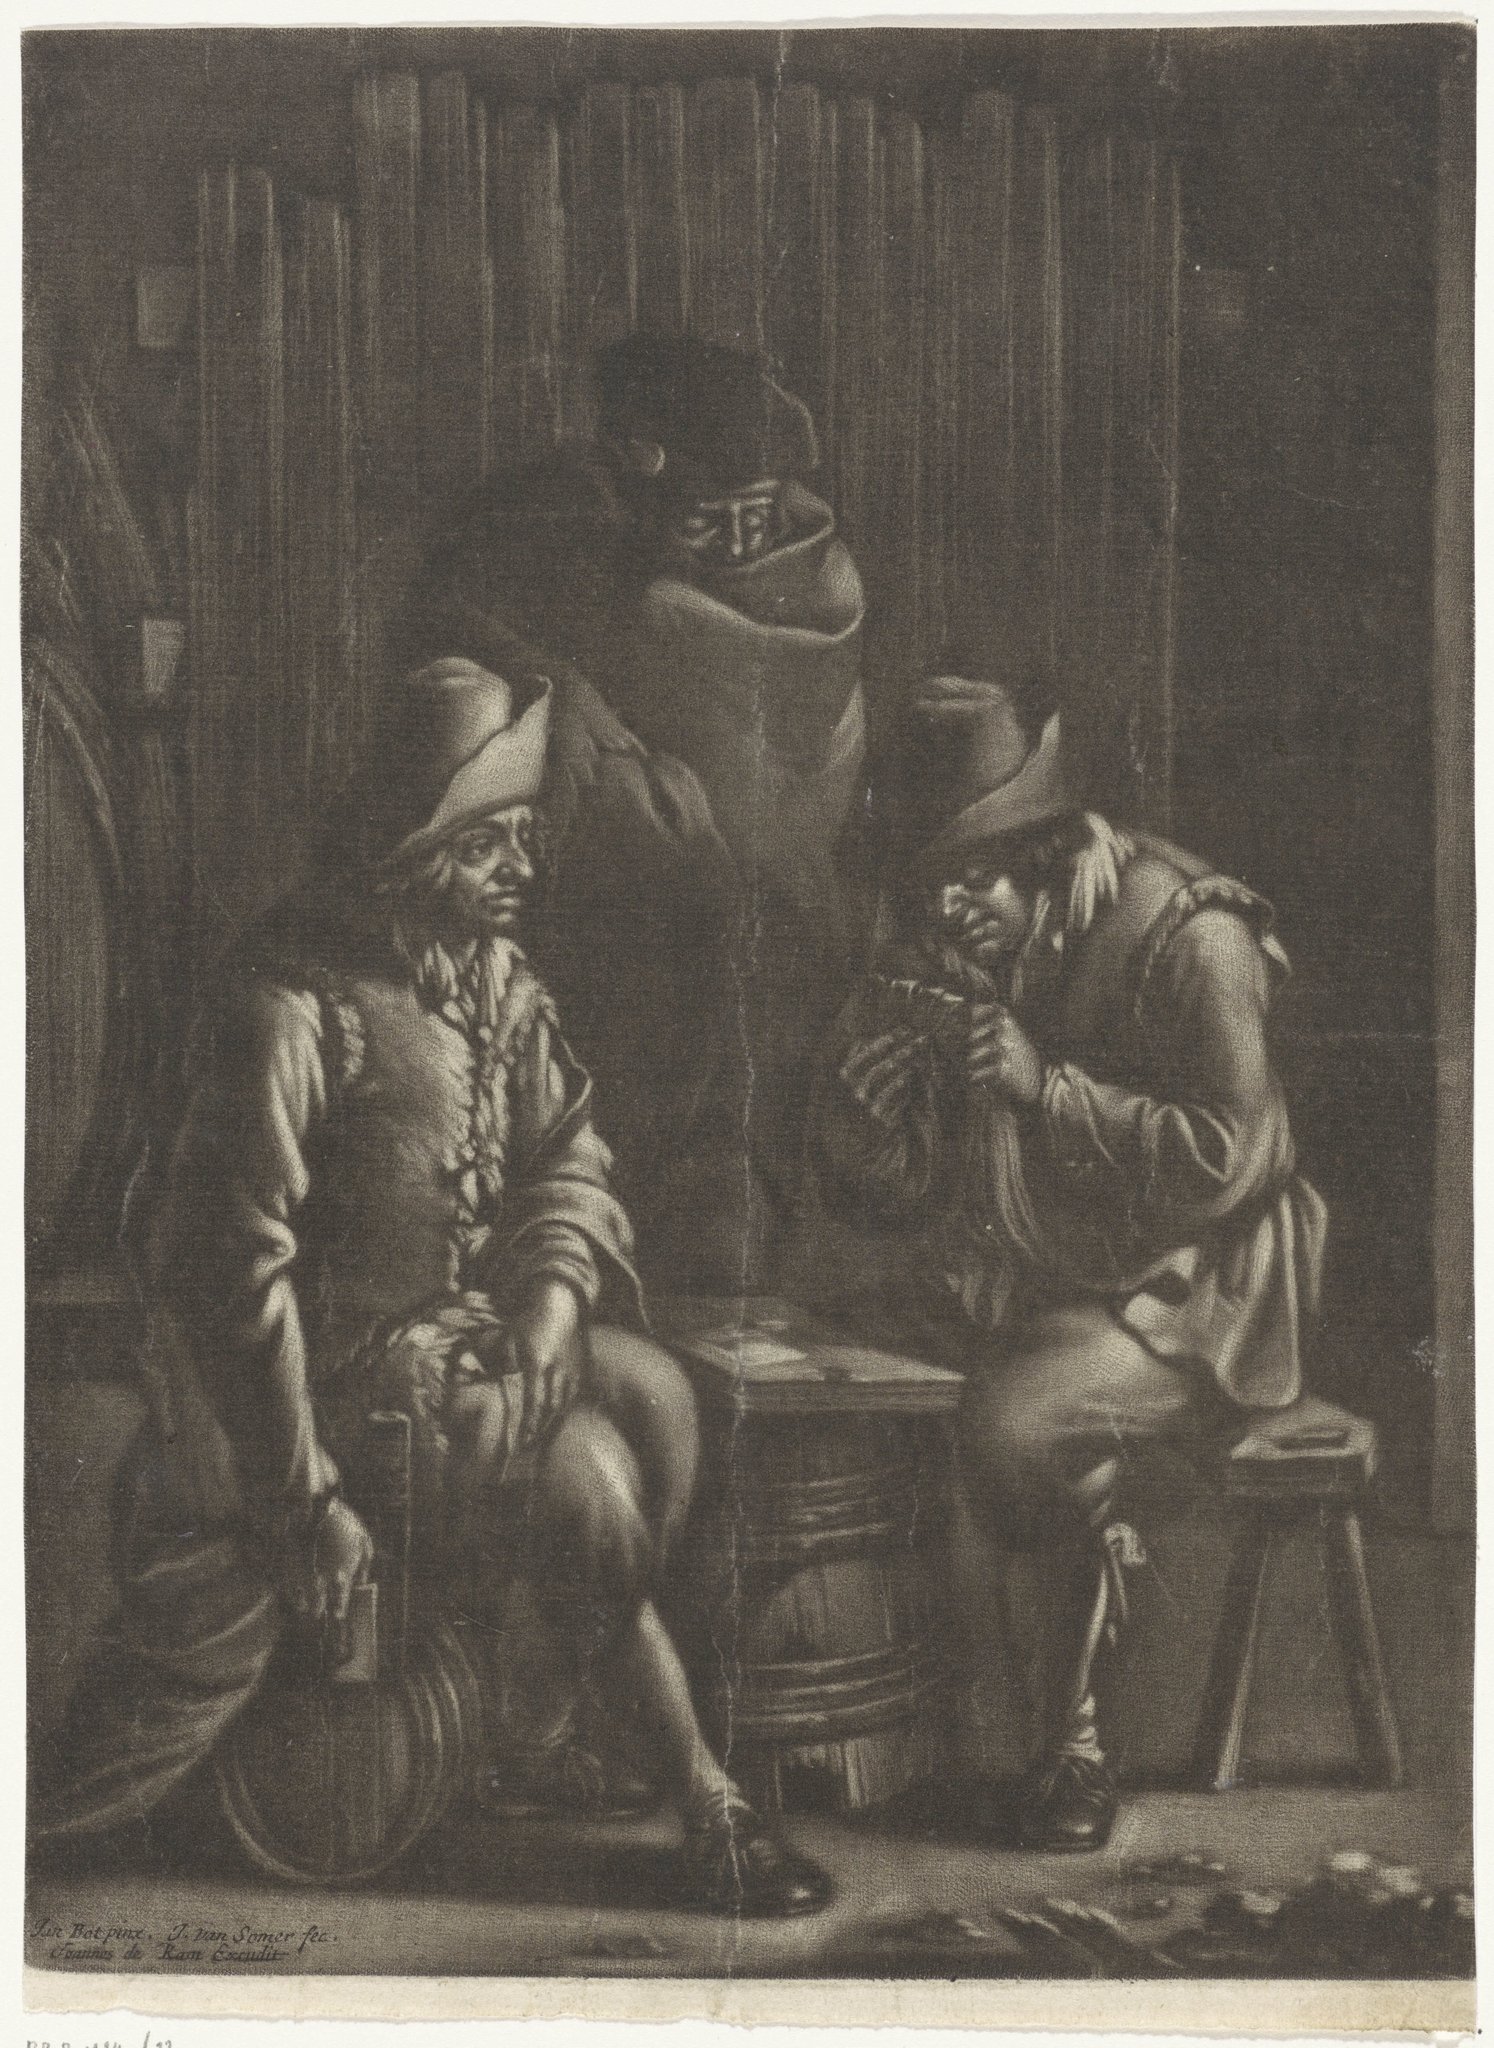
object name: print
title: Kaartspelers rond een vat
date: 1665-1693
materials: paper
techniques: mezzotint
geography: amsterdam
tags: playing-cards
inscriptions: collector's mark: Lugt 2233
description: Twee mannen spelen kaart rond een vat. Een derde man kijkt vanachter zijn mantel toe.